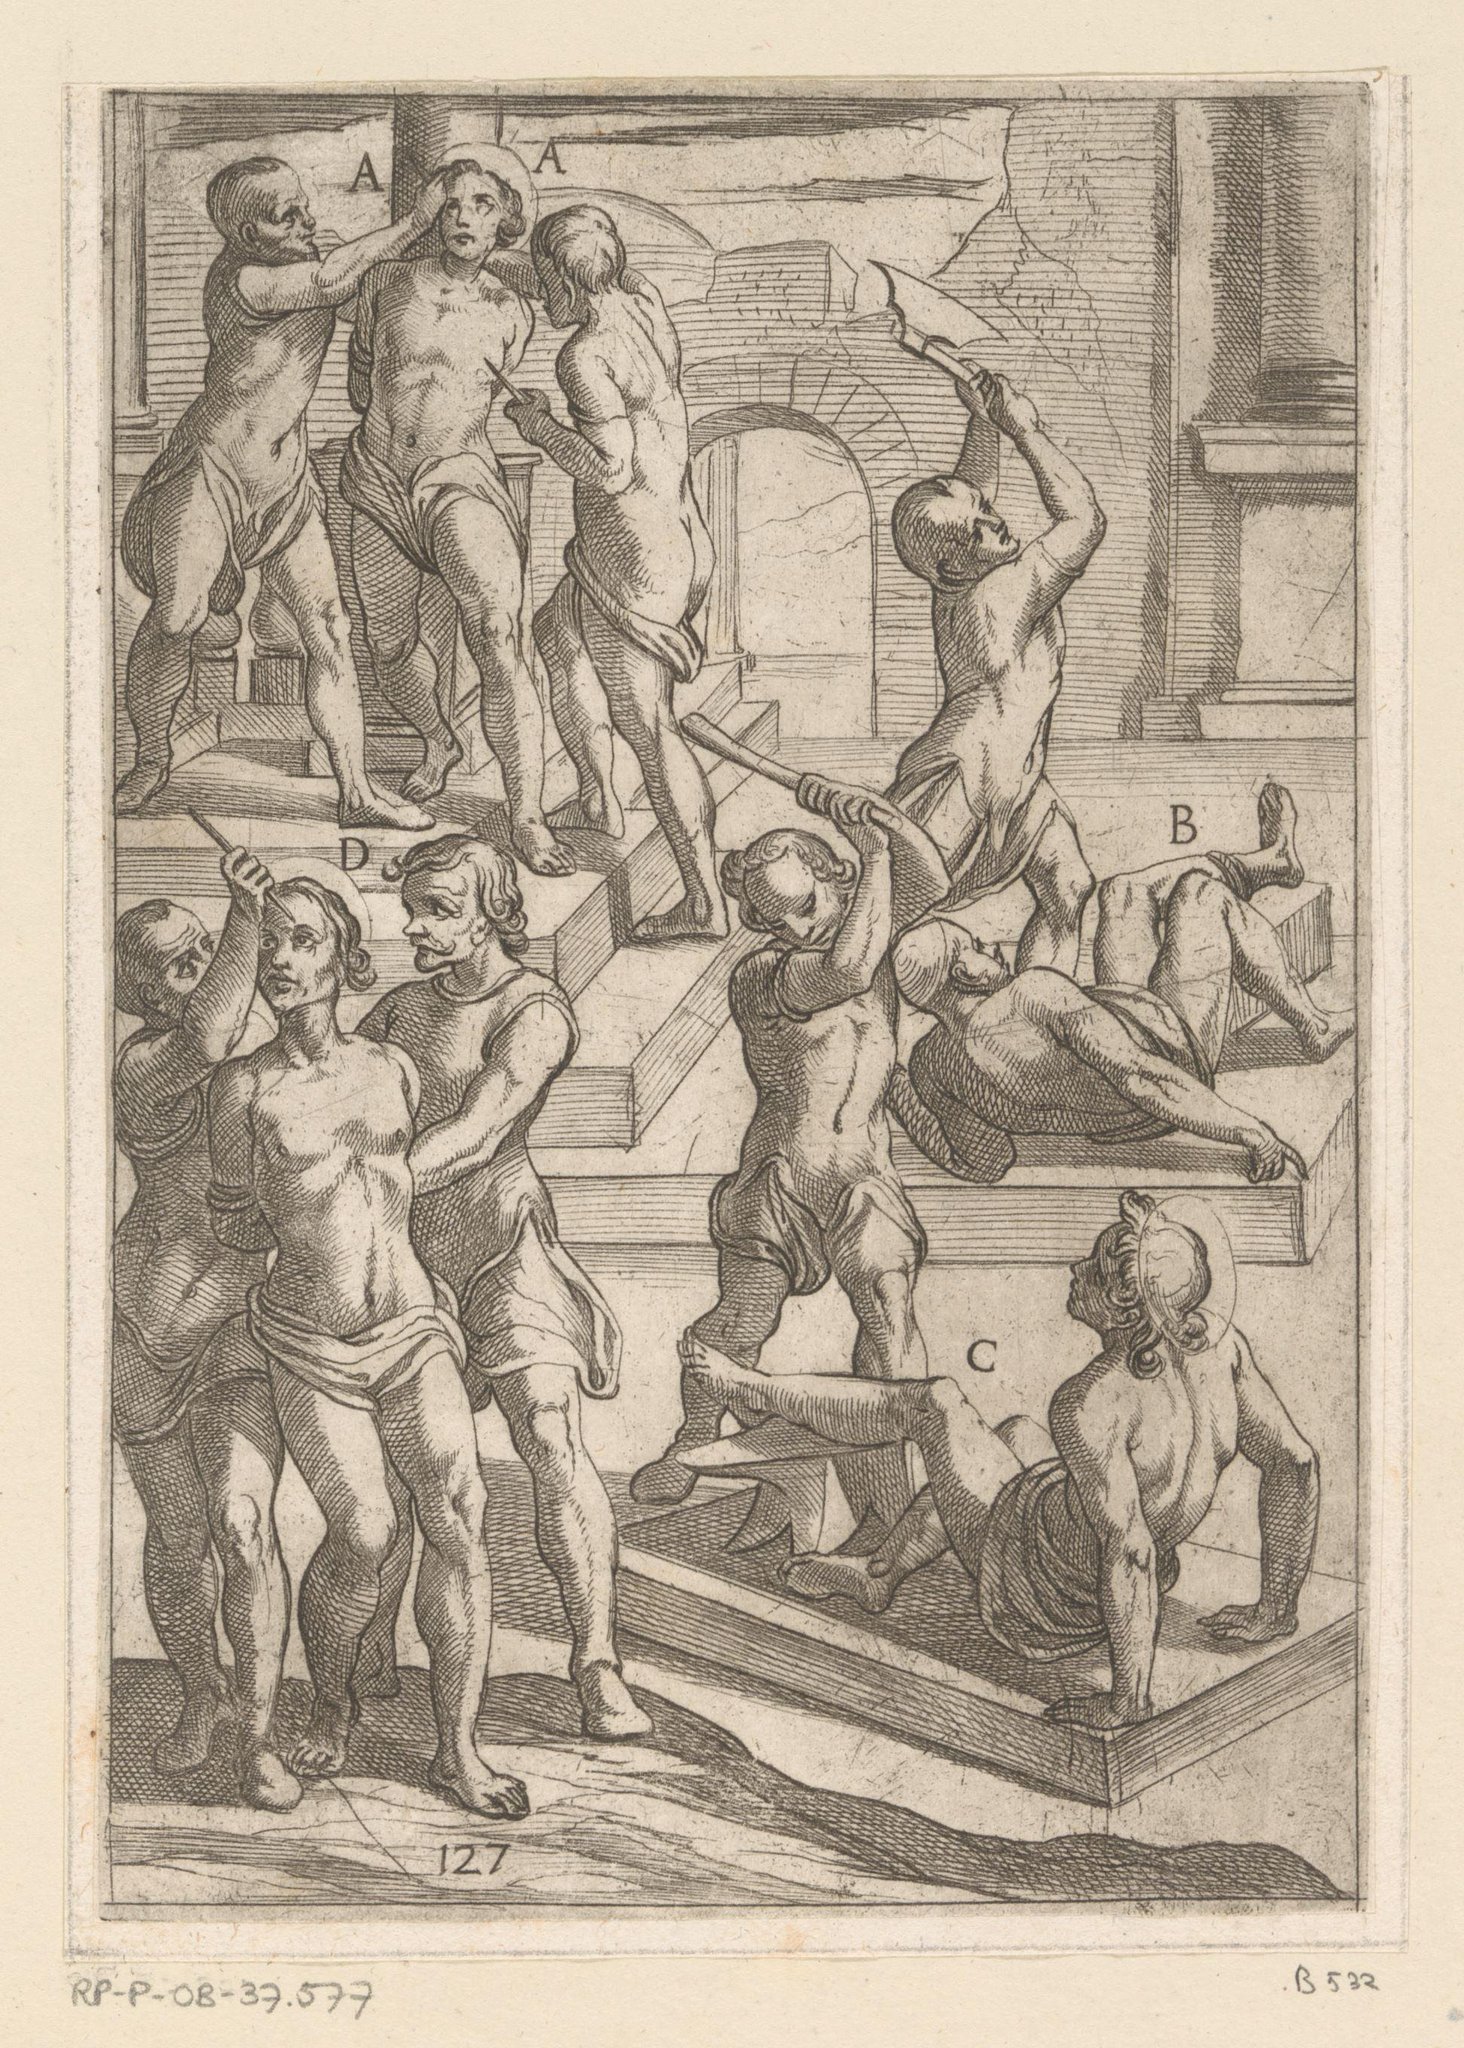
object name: print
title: Foltering: slaan, uitsteken van ogen en afhakken van ledematen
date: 1565-1630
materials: paper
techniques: etching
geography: italy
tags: violent death ~ maltreatment, torture, torture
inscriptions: collector's mark: Lugt 240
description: Deze prent maakt deel uit van een reeks van 47 prenten (+ titelprent) met voorstellingen van martelmethoden. Deze prenten zijn in een andere editie gebruikt als illustraties voor Antonio Gallonio's 'Trattato degli Instrumenti di Martirio e delle Varie Maniere di Martoriare Usate dai Gentili contro Christiani' (Rome, Ascanio en Girolamo Dongangeli, 1591).